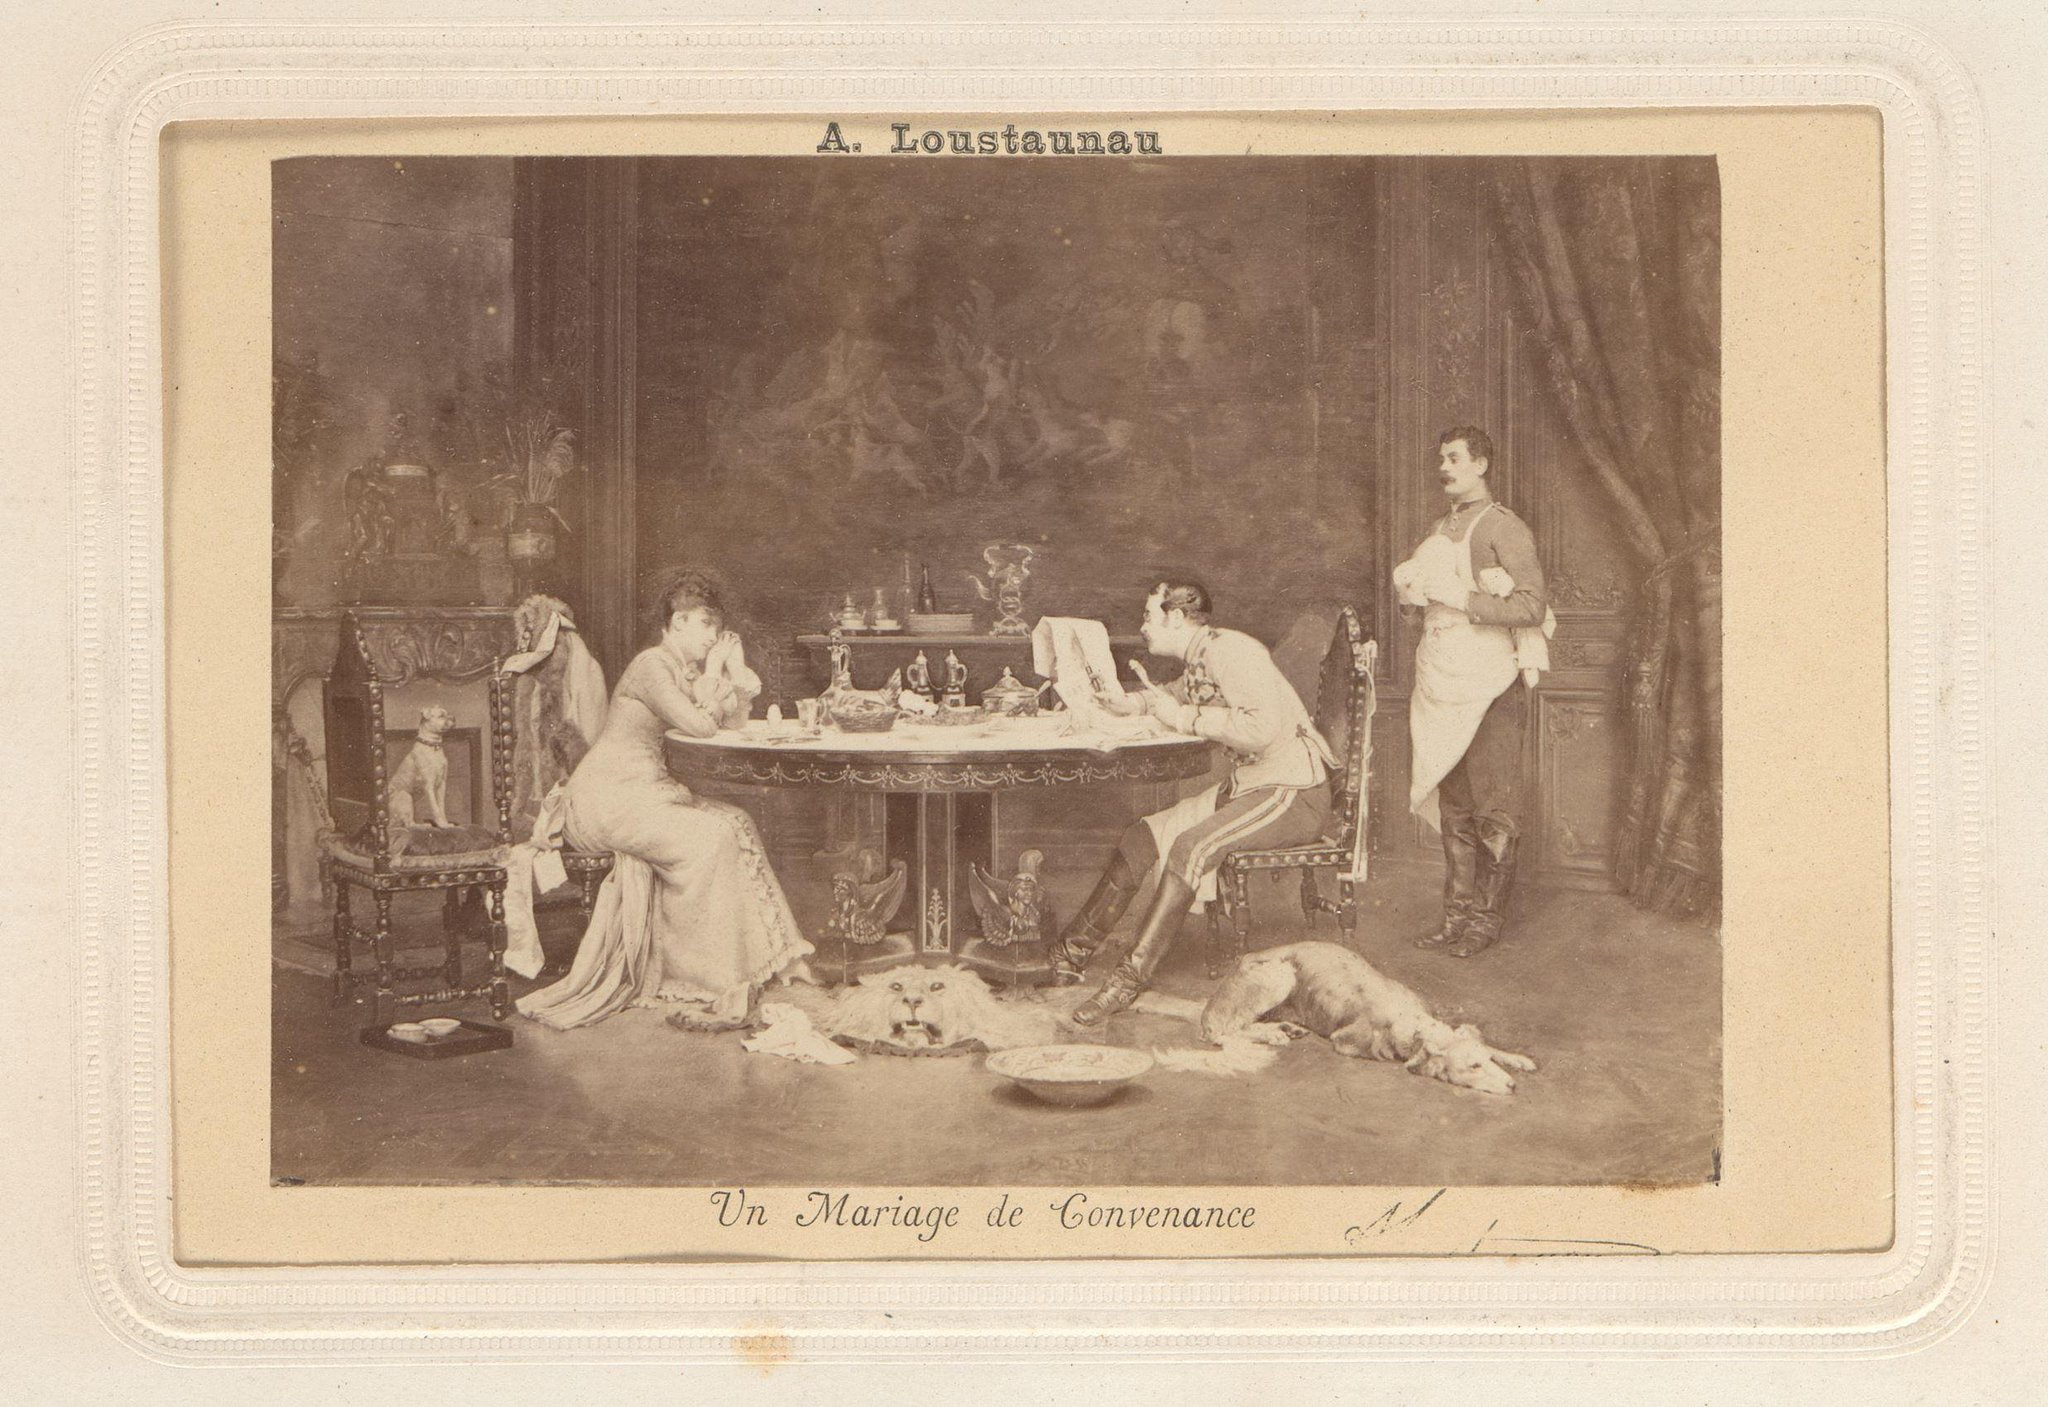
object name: reproduction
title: Fotoreproductie van het schilderij Un mariage de convenance naar Auguste Loustaunau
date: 1881-1900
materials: cardboard, paper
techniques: albumen print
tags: butler, marriage, married couple, 'matrimonium', dining-room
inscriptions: inscription: ‘A. Loustaunau/ Un Mariage de Convenance’